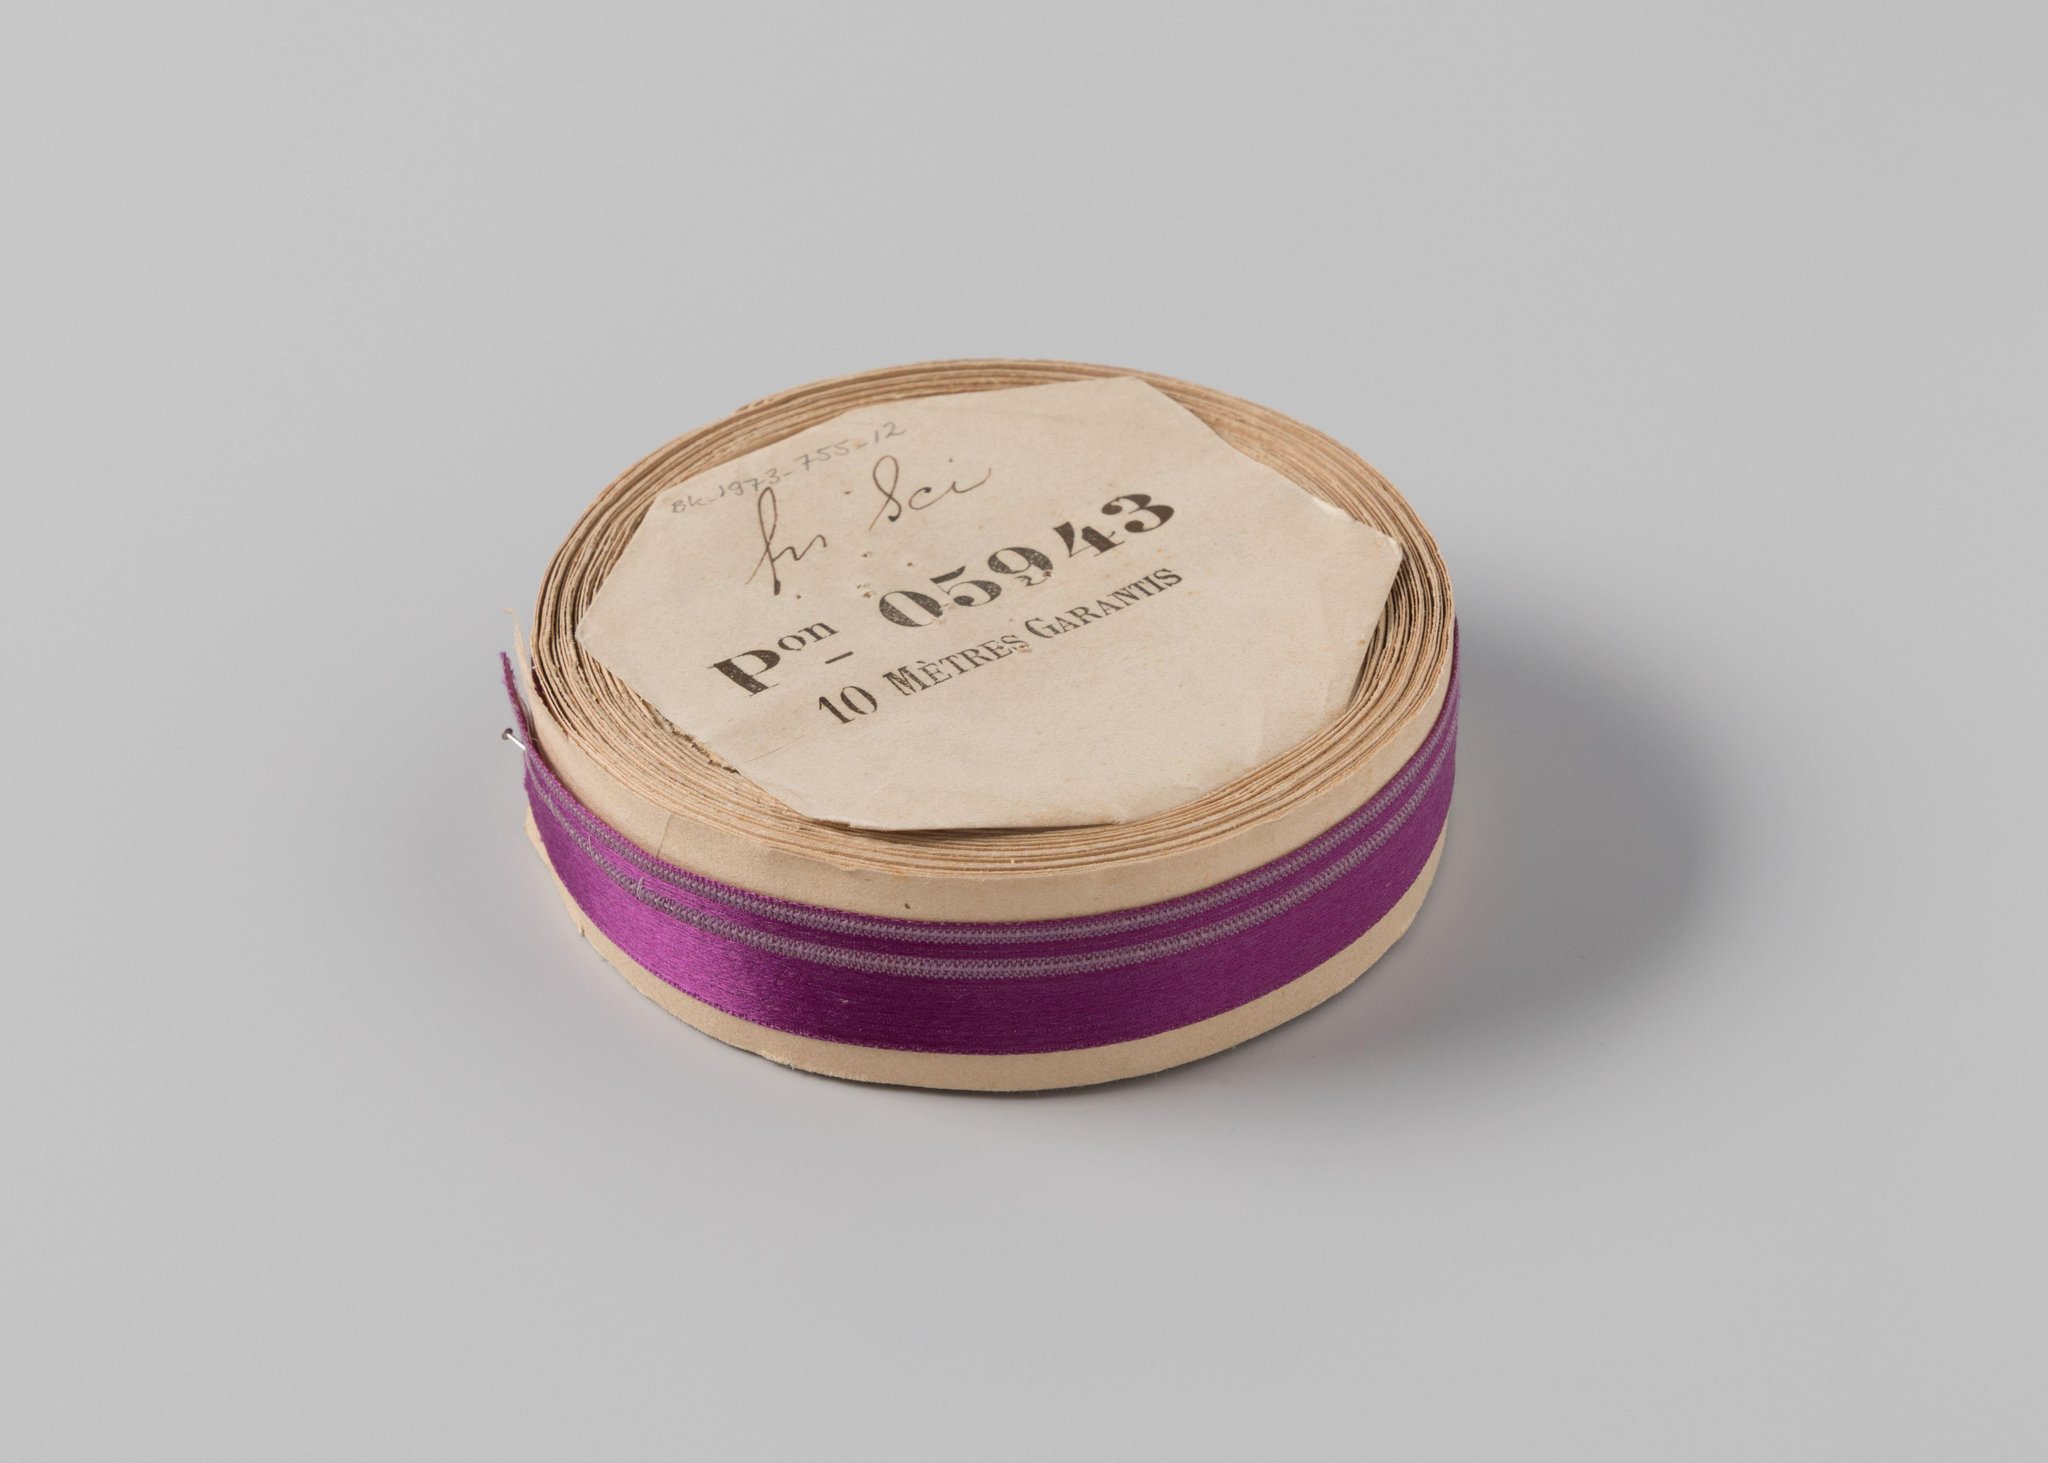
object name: ribbon material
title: Lint op rol, paars, aan één zijde twee strepen in lila met reliëf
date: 1890-1935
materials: cardboard, paper, textile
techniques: weave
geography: france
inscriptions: number: ‘Pon 05943’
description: Lint op rol, paars, aan één zijde twee strepen in lila met reliëf.